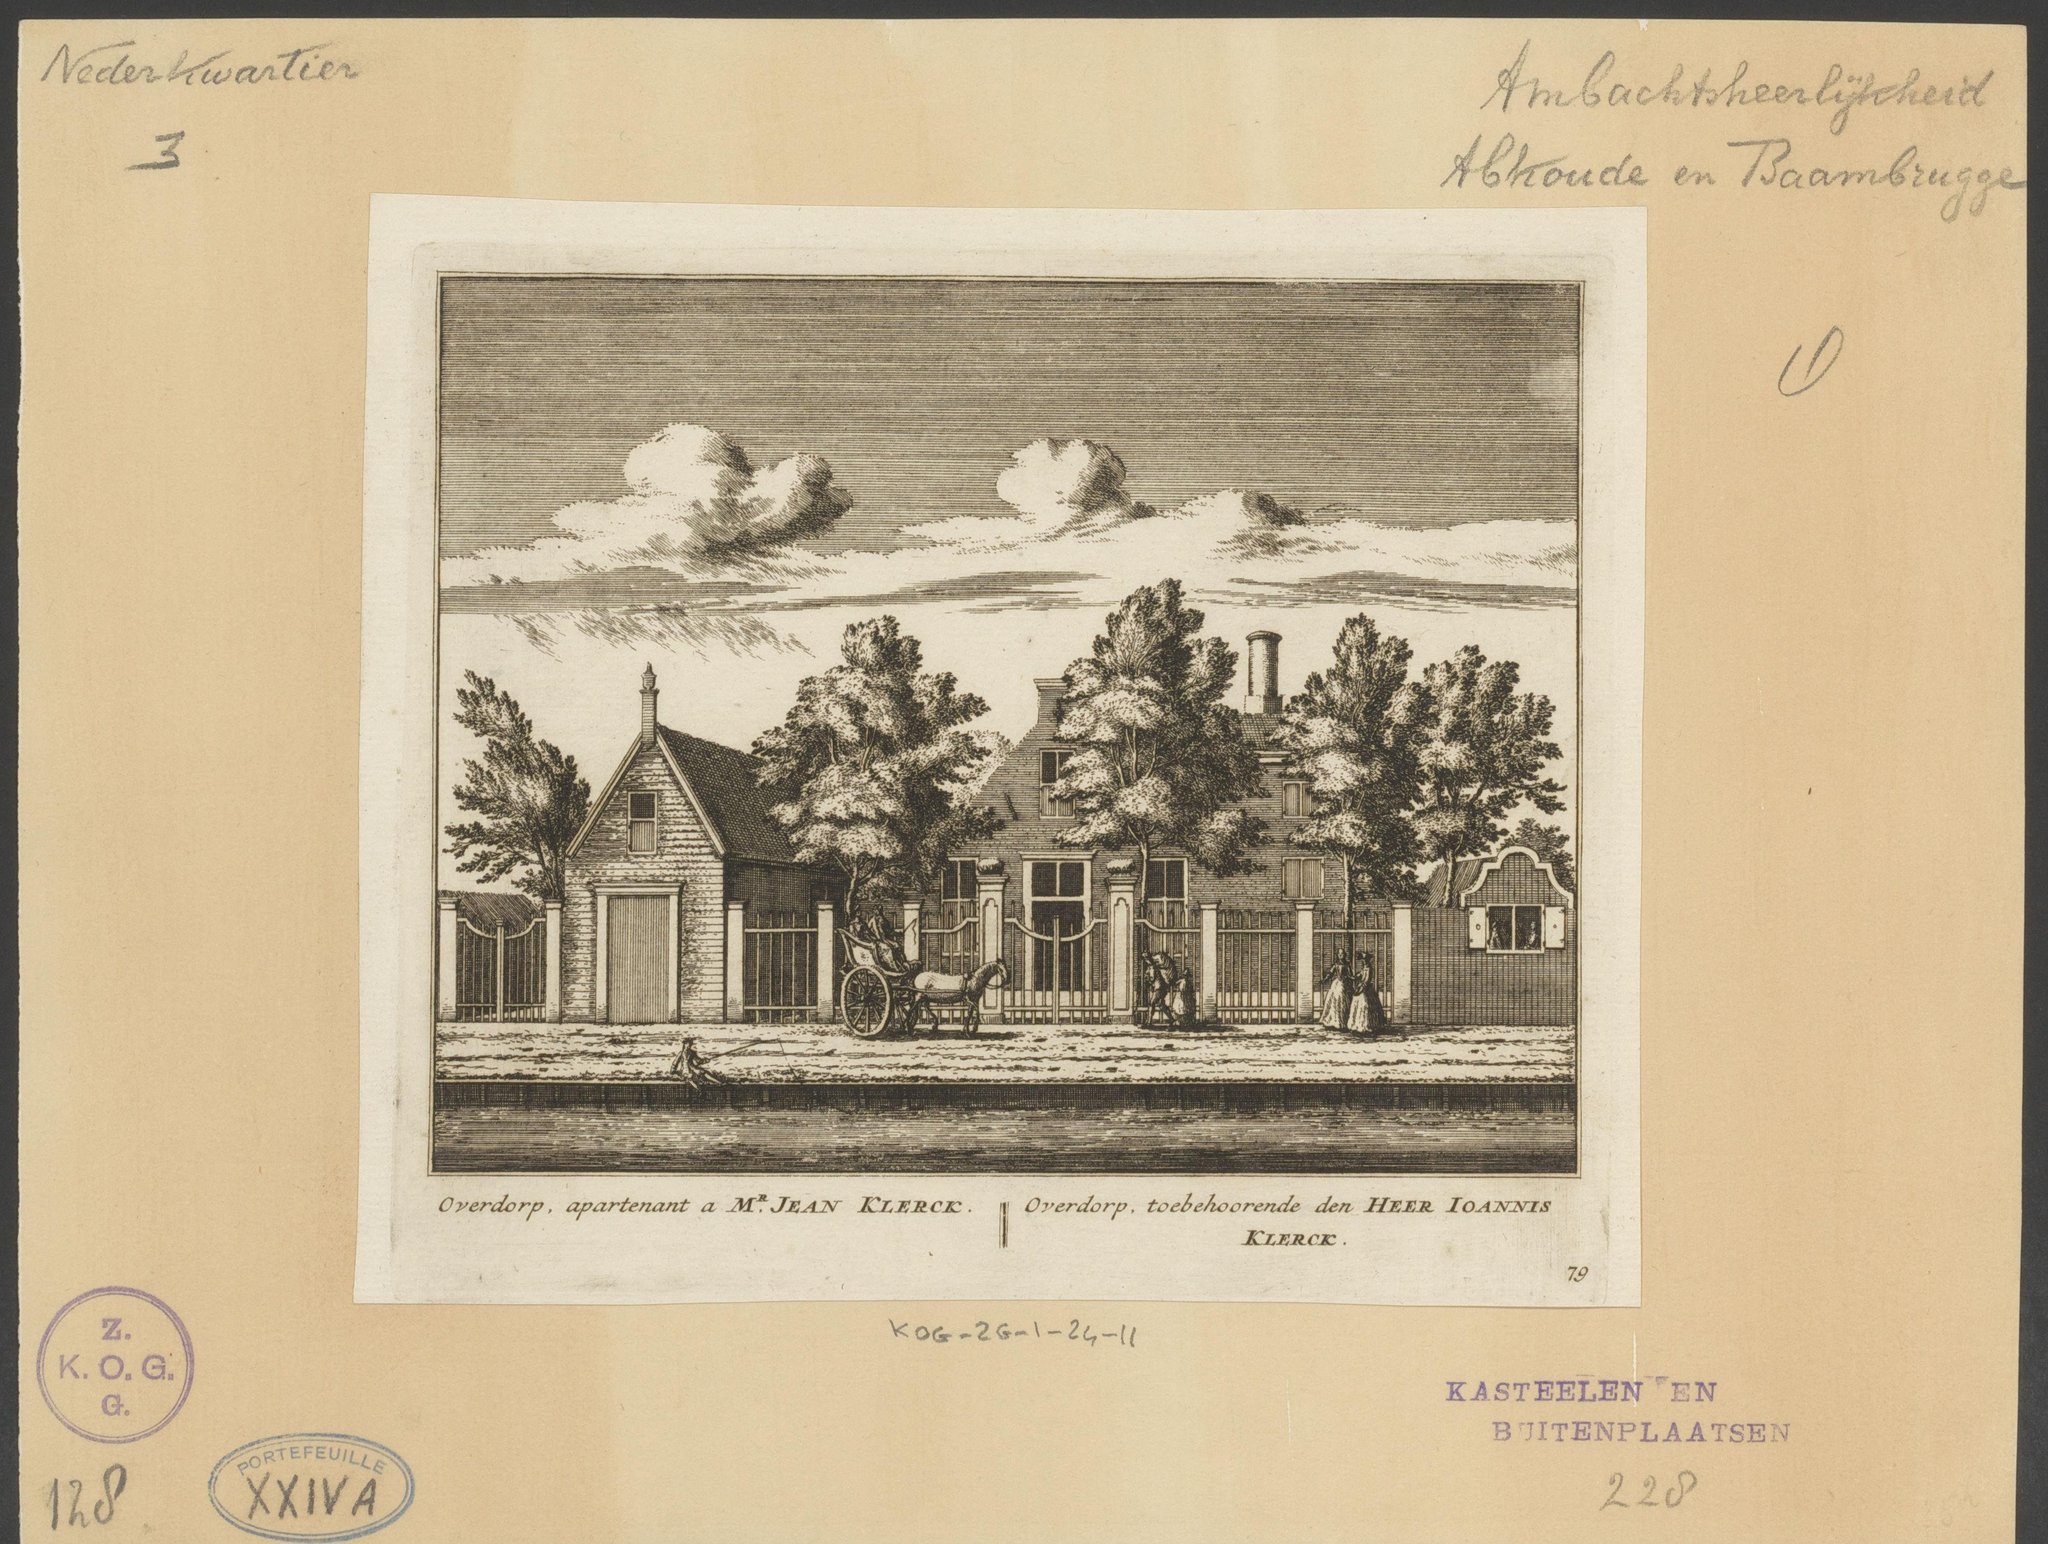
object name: print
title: Overdorp, apartenant a mr. Jean Klerck / Overdorp, toebehoorende den heer Ioannis Klerck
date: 1730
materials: paper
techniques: etching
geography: amsterdam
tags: rural housing, e.g. country-house, villa, cottage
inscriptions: stamp, collector's mark: Lugt 1641, stamp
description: Rechtsonder genummerd: 79. Onderwerpsrubrieken binnen de Atlas Zeden en Gewoonten: Zeden en Gewoonten in Engeren Zin, De Woning. Kastelen en buitenplaatsen. Utrecht (vervolg.).